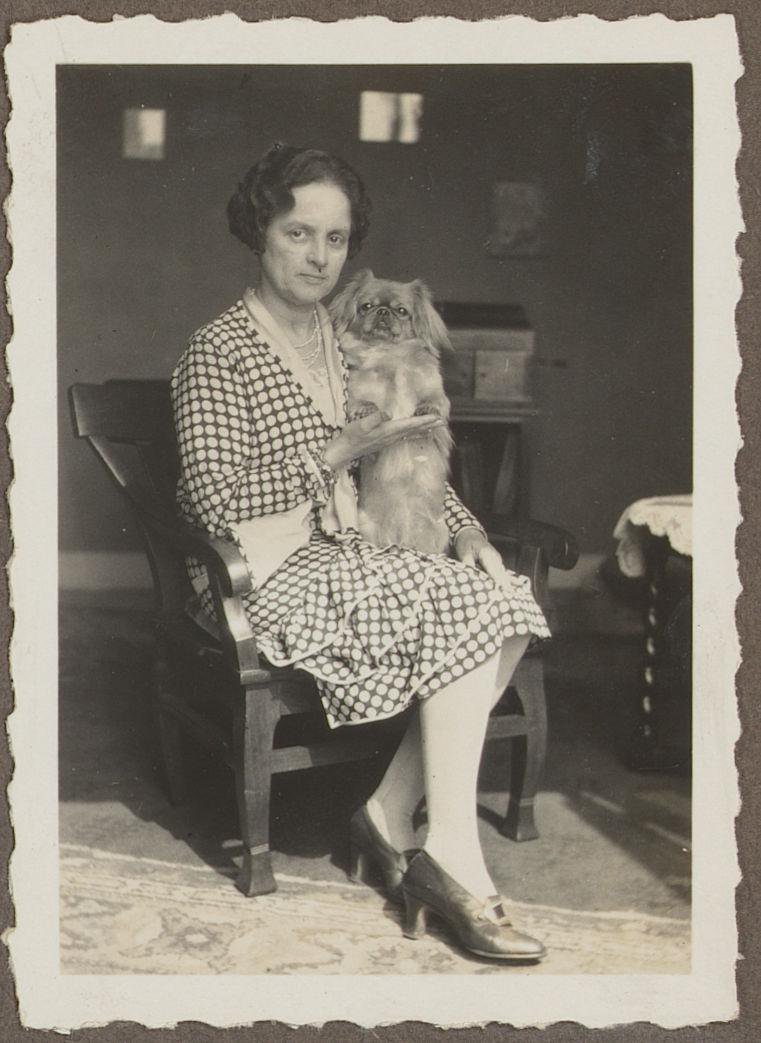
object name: photograph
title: Portret van Henriëtte Wassink met een hond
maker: Anonymous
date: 1930-1935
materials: paper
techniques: gelatin silver print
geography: netherlands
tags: batavia, the hague, henriëtte wassink, historical persons - bb - woman, dog, netherlands